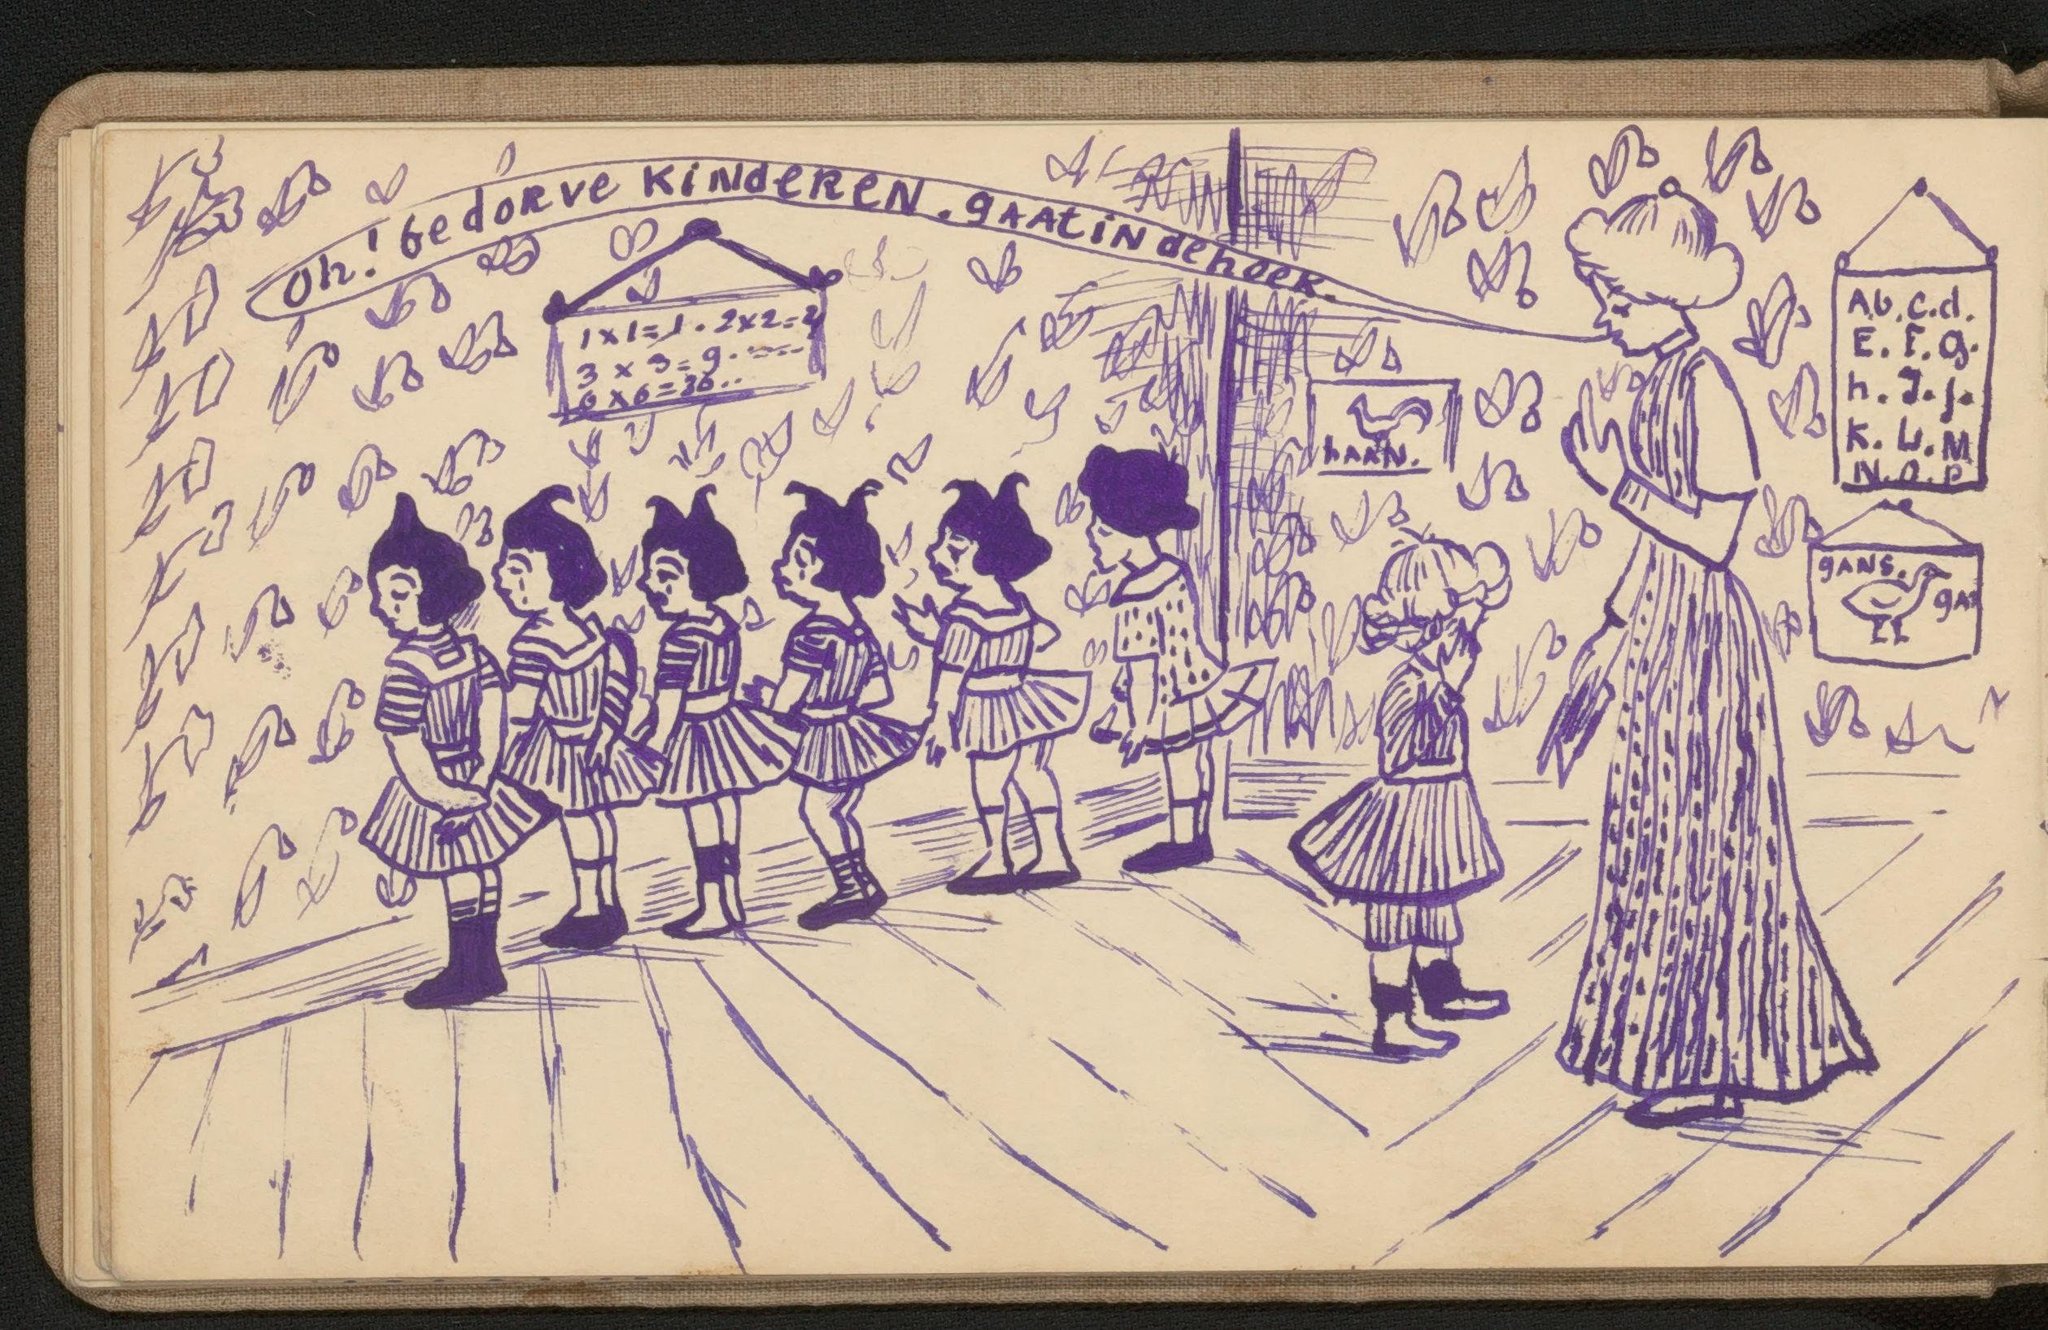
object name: sketchbook leaf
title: Stoute kinderen moeten in de hoek staan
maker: Anonymous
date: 1875-1920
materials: ink, paper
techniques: pen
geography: netherlands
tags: baby-sitter, the naughty child, family life at home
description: Stoute kinderen moeten van de nieuwe juffrouw in de hoek staan. Onderdeel van het schetsboek met humoristische tekeningen over het leven van een 'famille nombreuse'. Onderwerpsrubrieken binnen de Atlas Zeden en Gewoonten: Zeden en Gewoonten in Engeren Zin, Des menschen beging, midden en einde, Kinderleven.